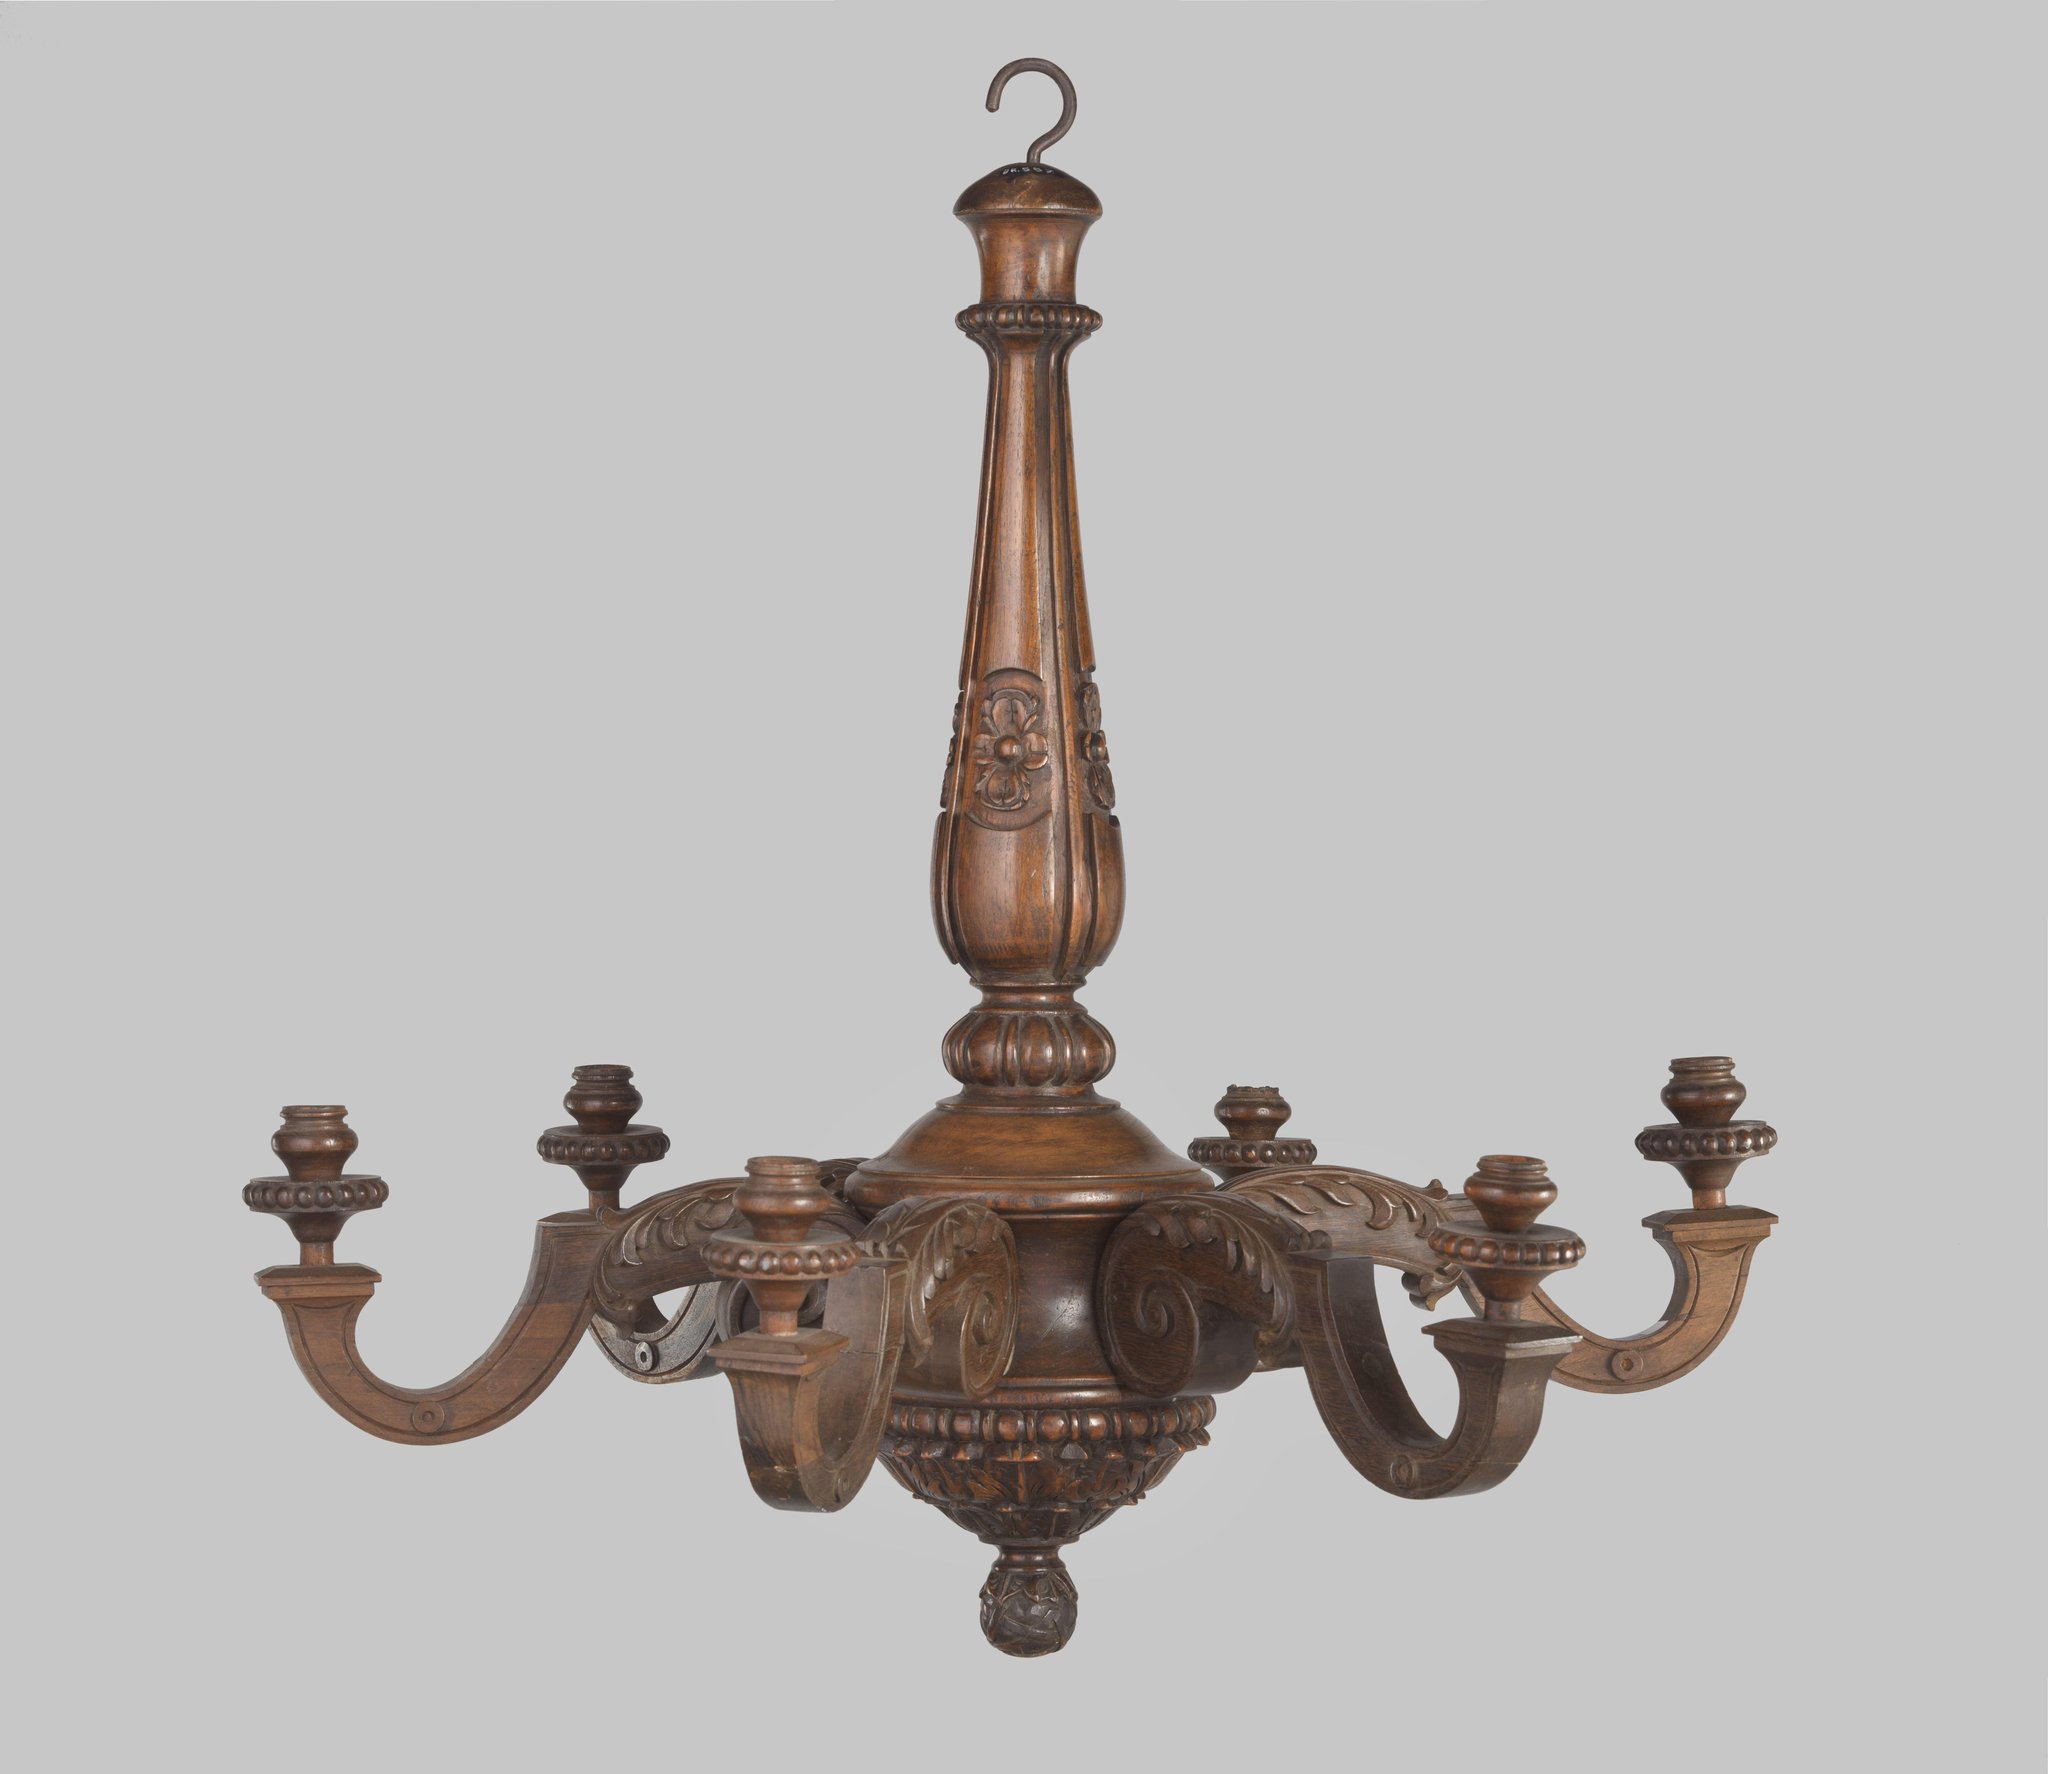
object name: interieuronderdeel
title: Kroonluchter van hout met zes armen.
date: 1700-1800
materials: wood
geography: indonesia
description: Two candlesticks and two candelabra. Silver. Rotterdam, 1789 and 1791, by Cornelis Knuysting. On loan from the Remonstrant Reformed Church, Amsterdam.